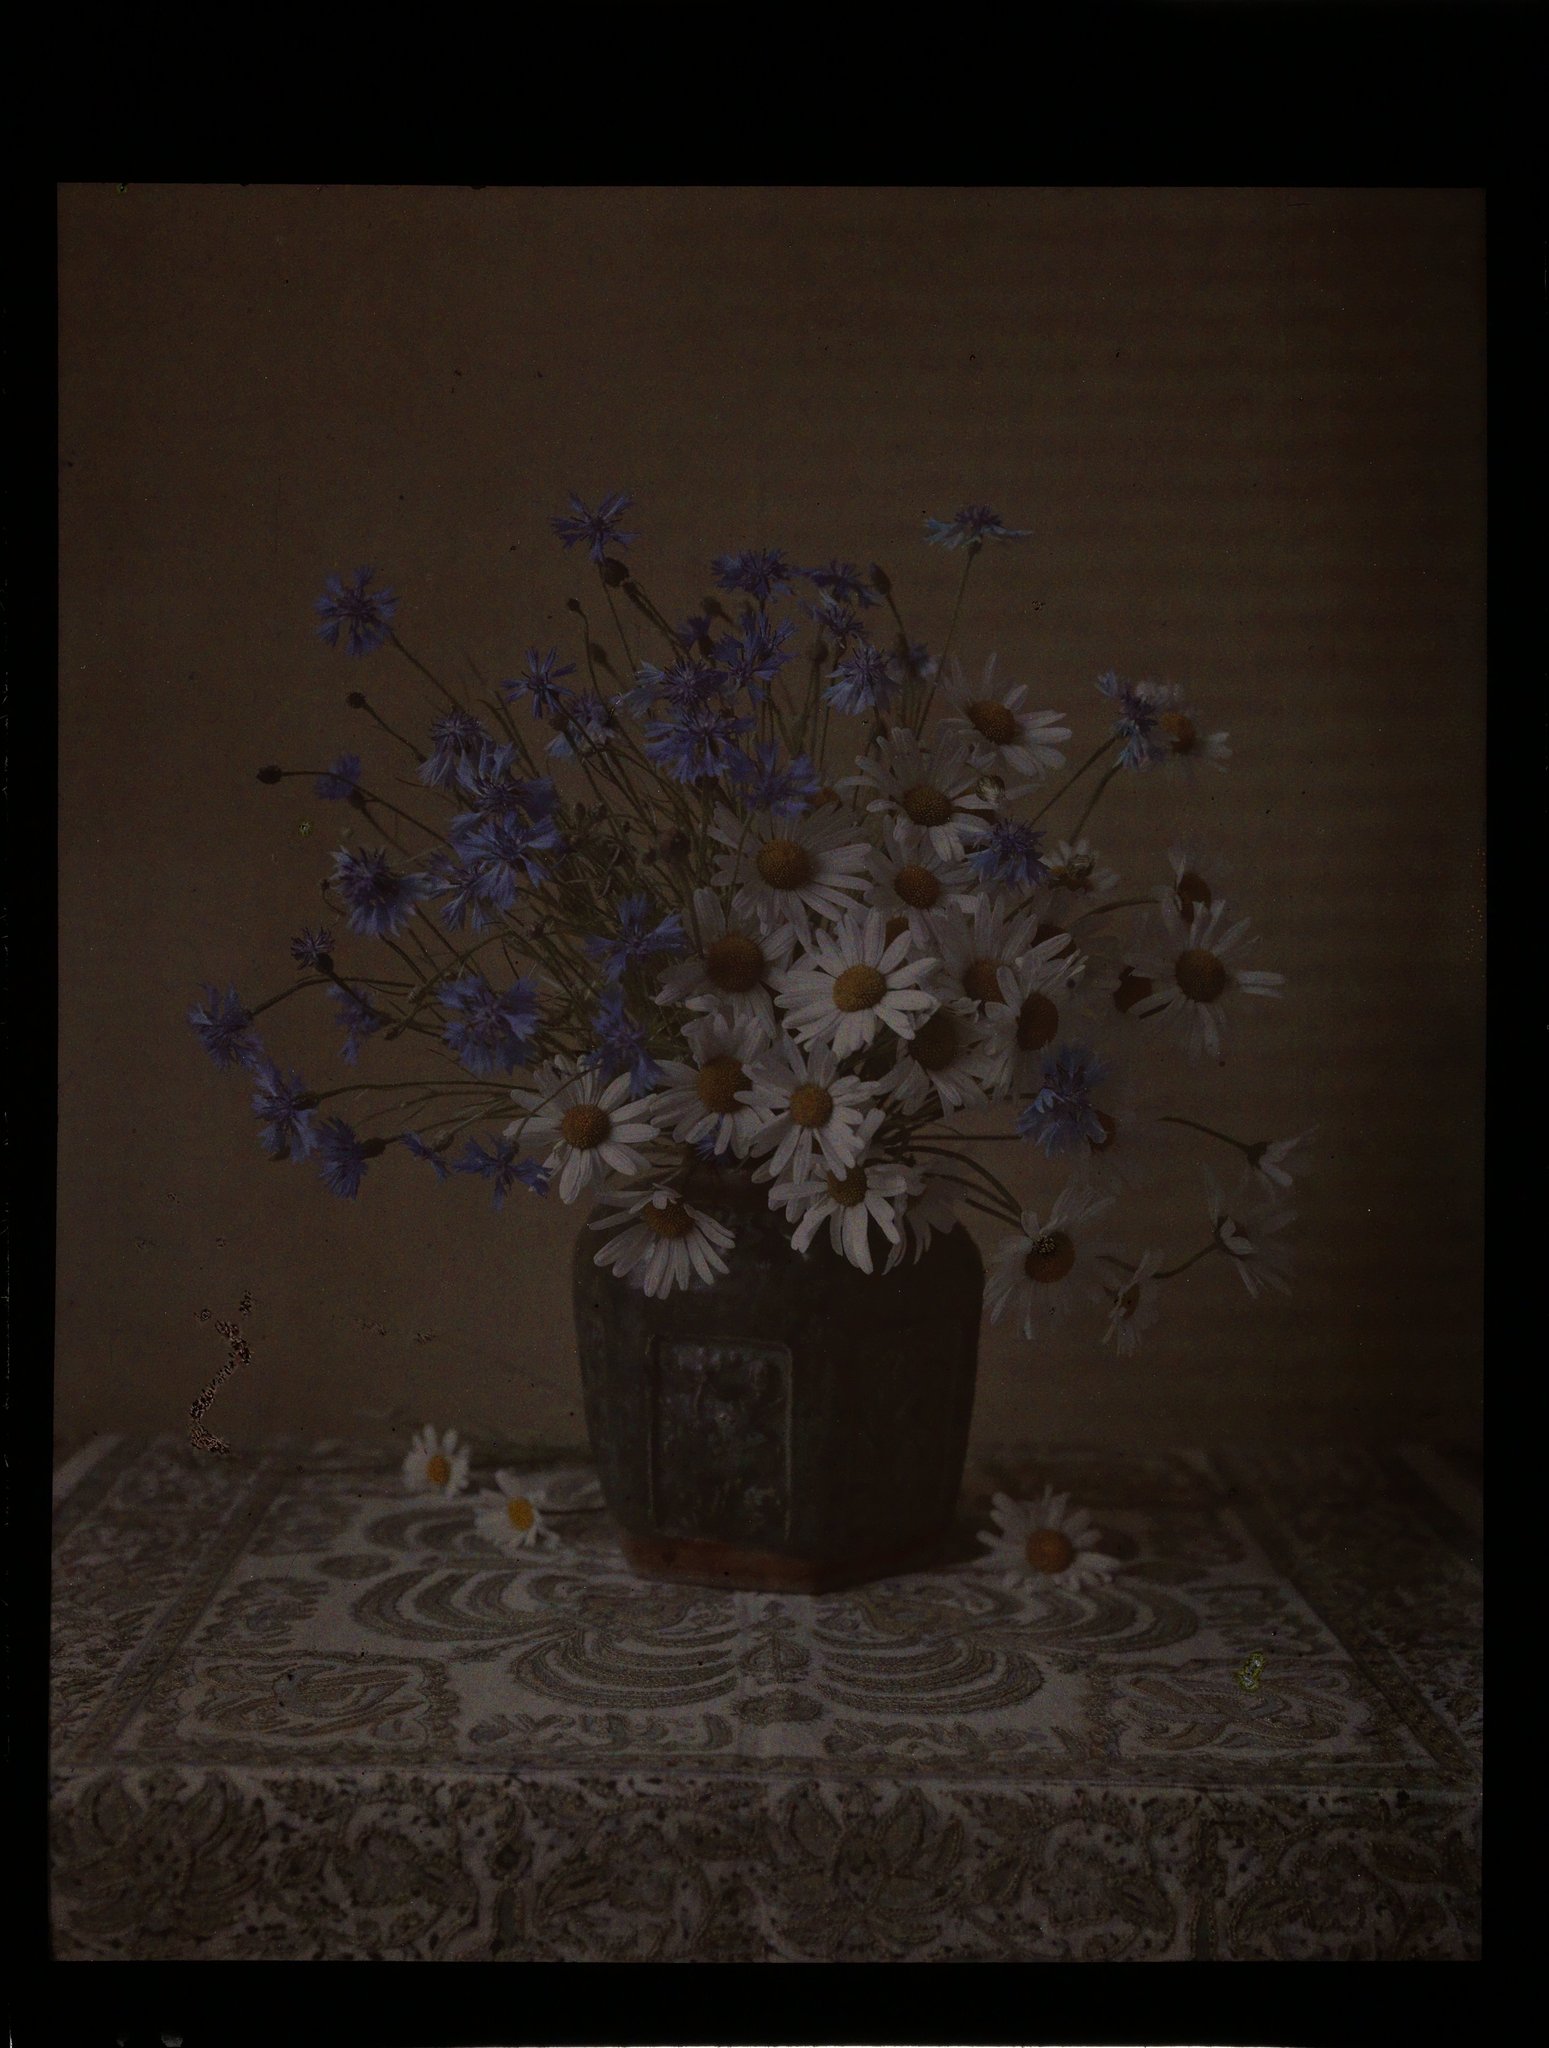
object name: photograph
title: Vaas met margrieten en korenbloemen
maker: Anonymous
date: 1907-1935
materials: glass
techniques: autochrome process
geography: netherlands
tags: flowers in a vase, netherlands